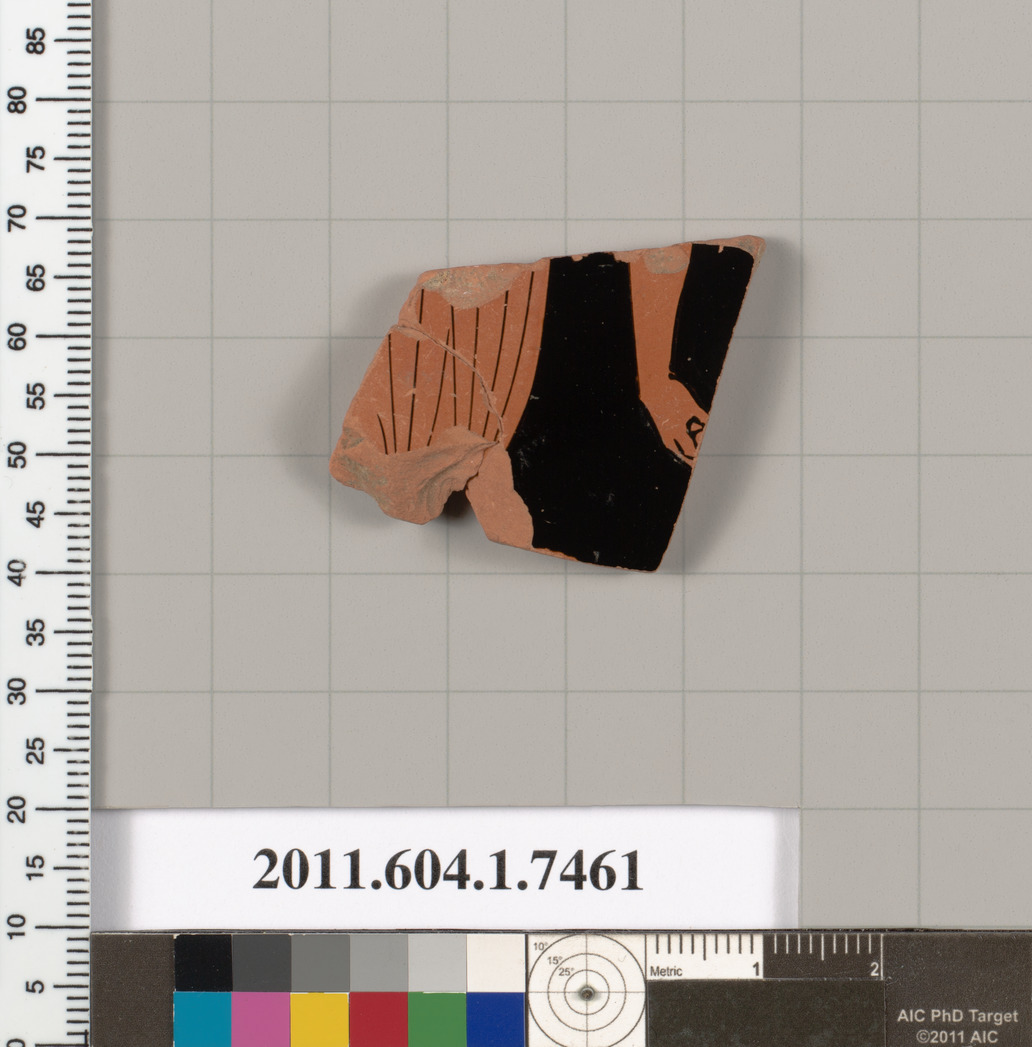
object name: kylix fragment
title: Terracotta fragment of a kylix (drinking cup)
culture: greek, attic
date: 470-460 BCE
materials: terracotta